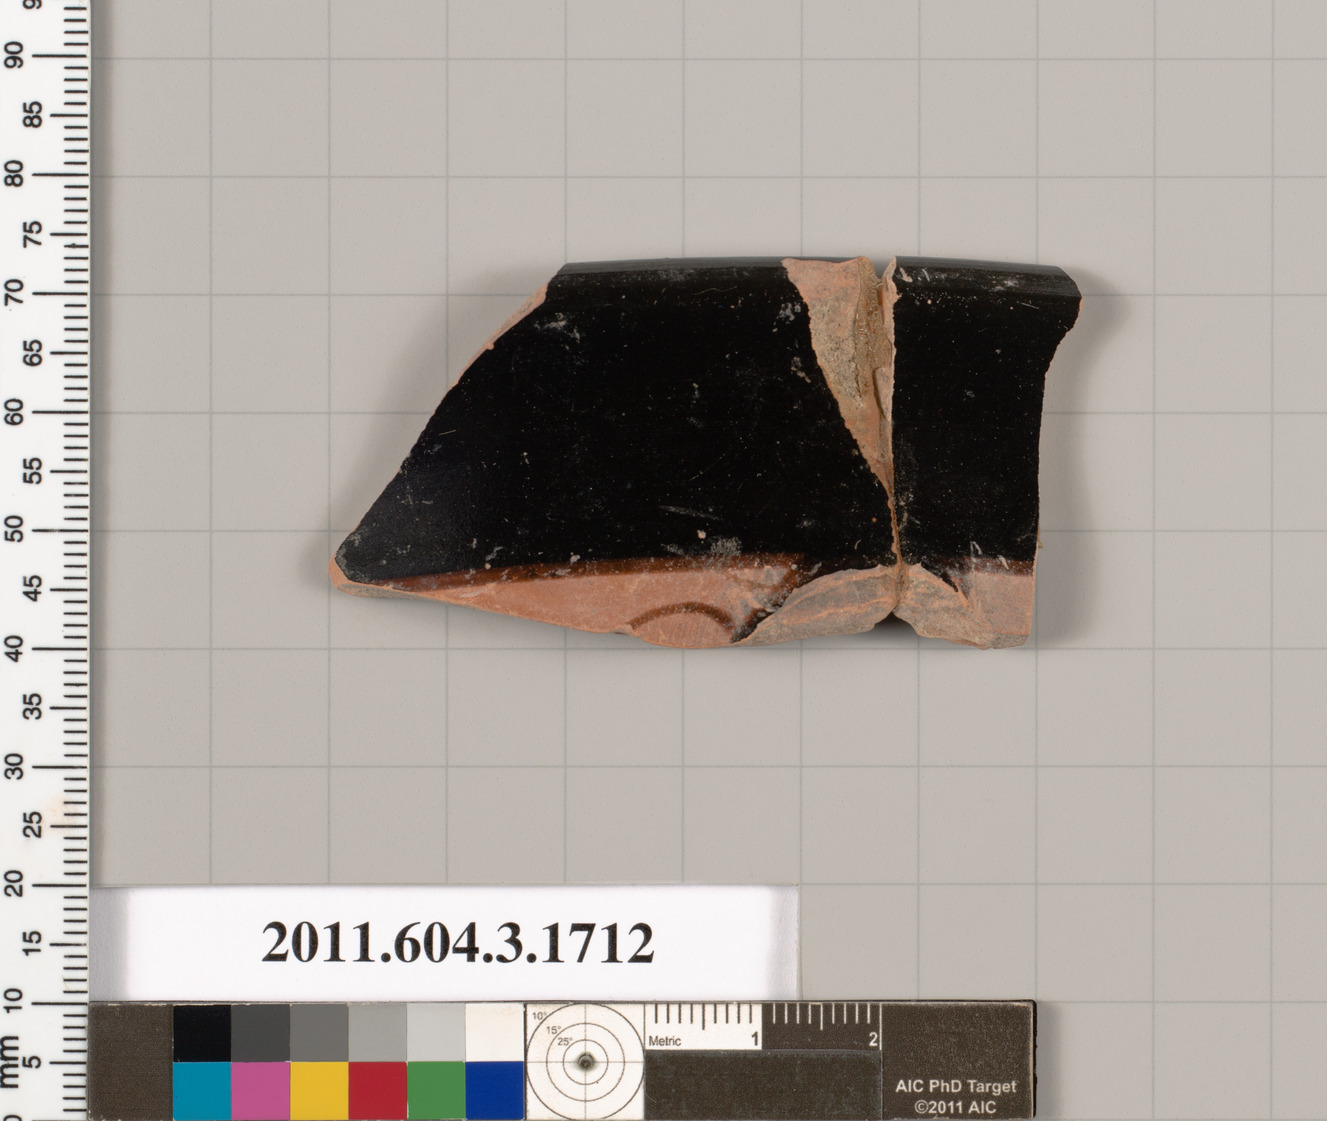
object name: kylix fragment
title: Terracotta rim fragment of a kylix: Band cup (drinking cup)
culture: greek, attic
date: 550-526 BCE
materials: terracotta